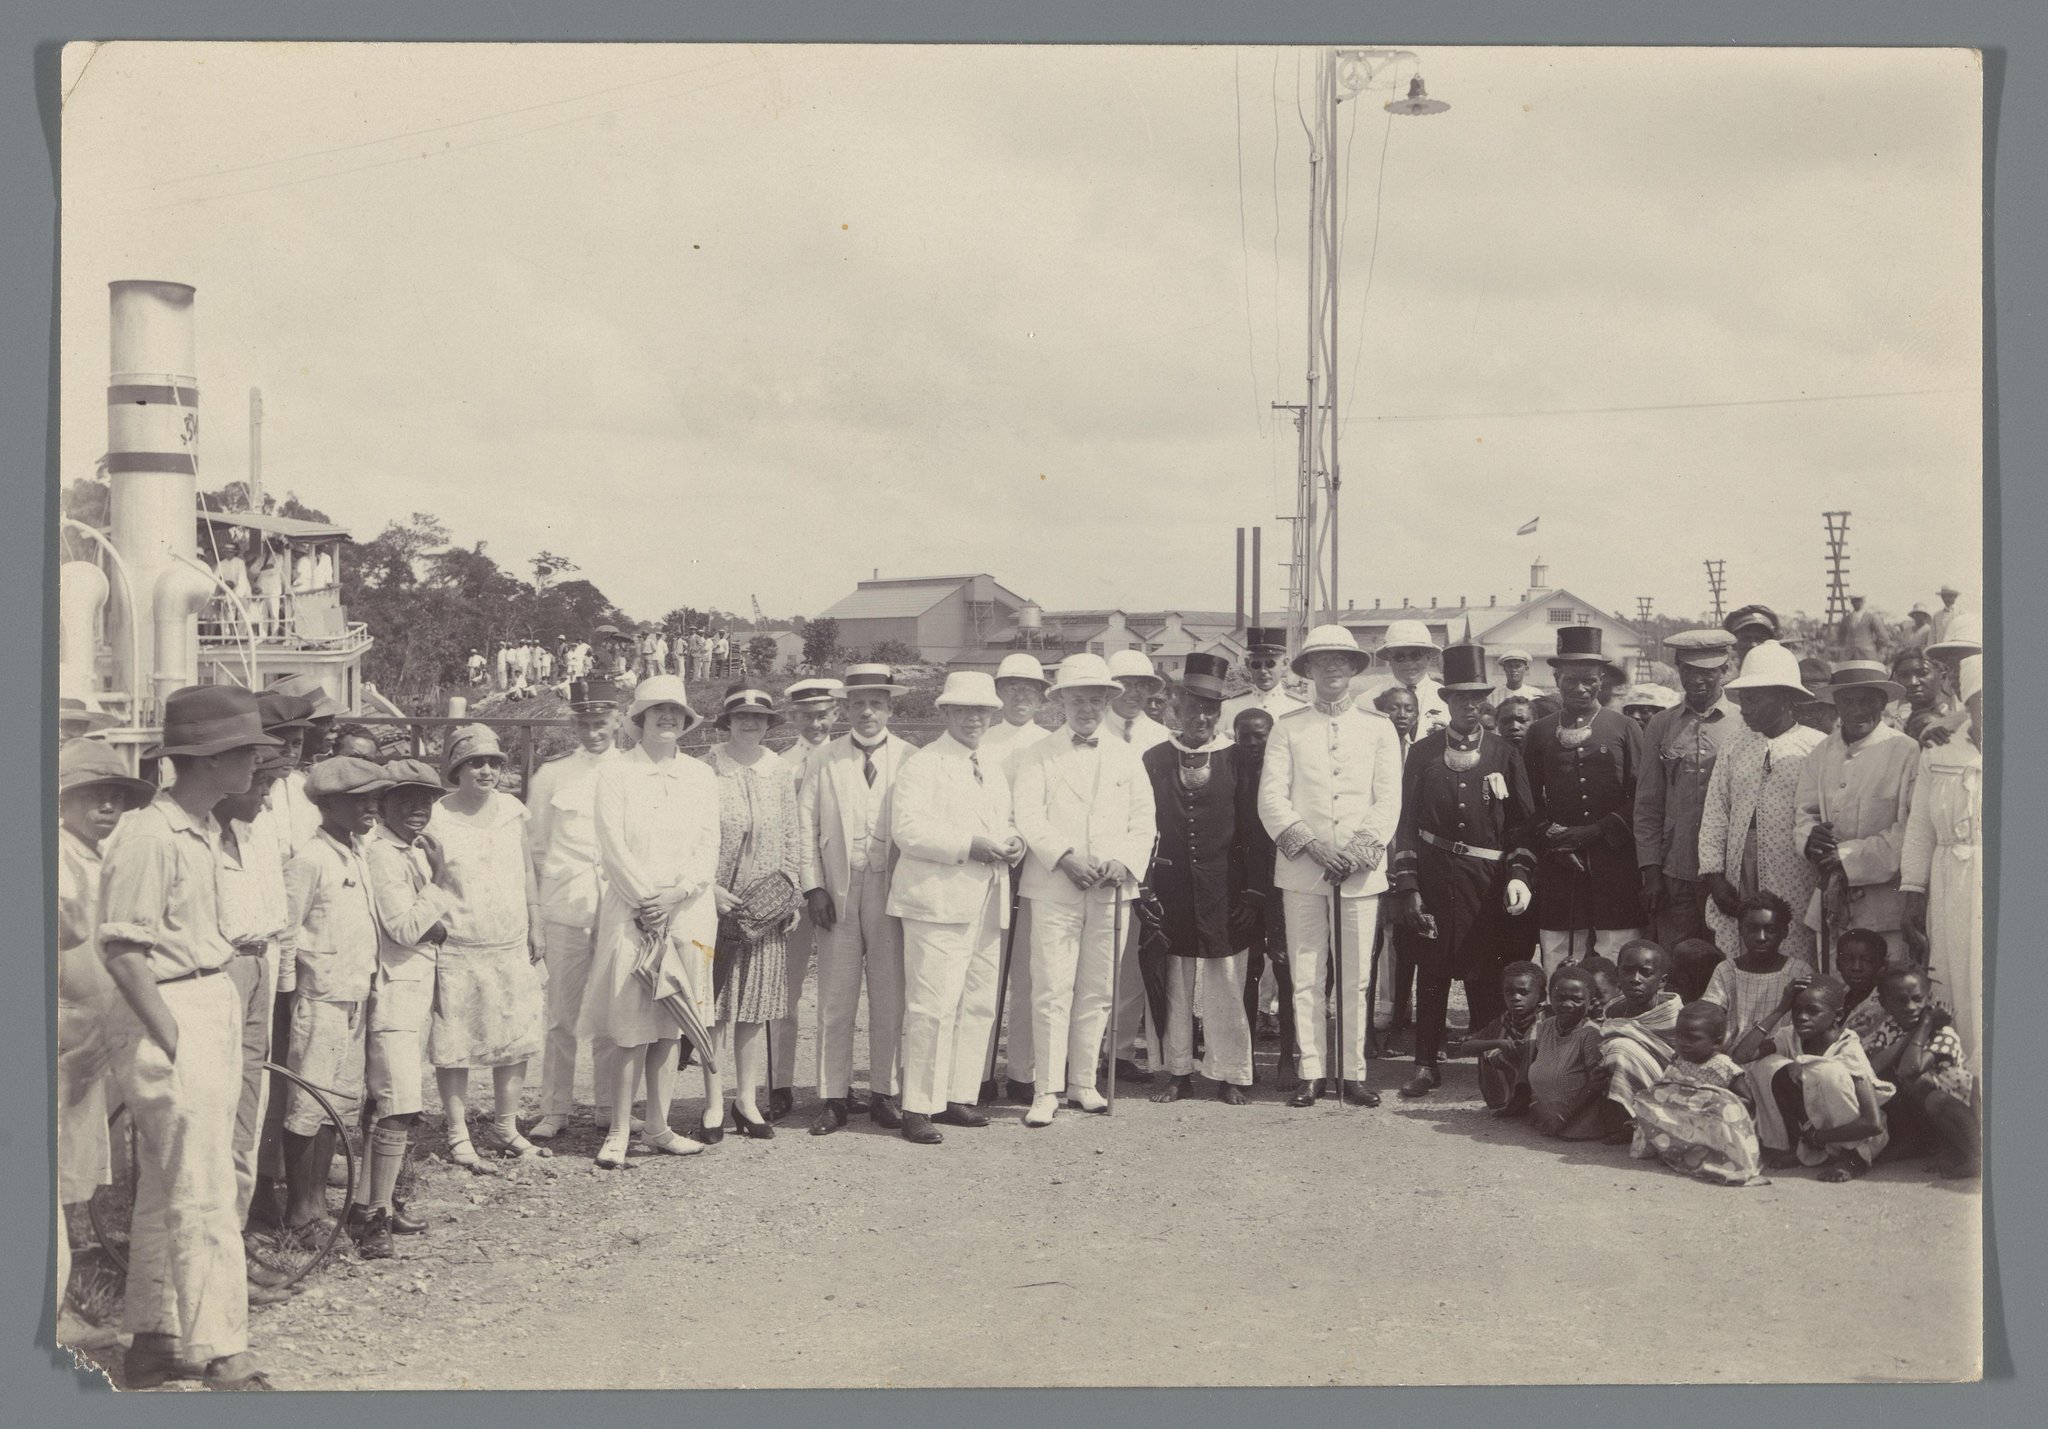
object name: photograph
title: Groepsfoto bij de fabriek te Moengo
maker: Anonymous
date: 1925-1927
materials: photographic support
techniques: photography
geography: suriname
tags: jetten, familie, moengo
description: Groepsfoto van Nederlanders en Surinamers op het terrein van de fabriek te Moengo. Met ingenieur en Edith Jetten. Onderdeel van het ensemble met foto's van de familie van ingenieur Jetten in de mijnbouwstad Moengo in Suriname.